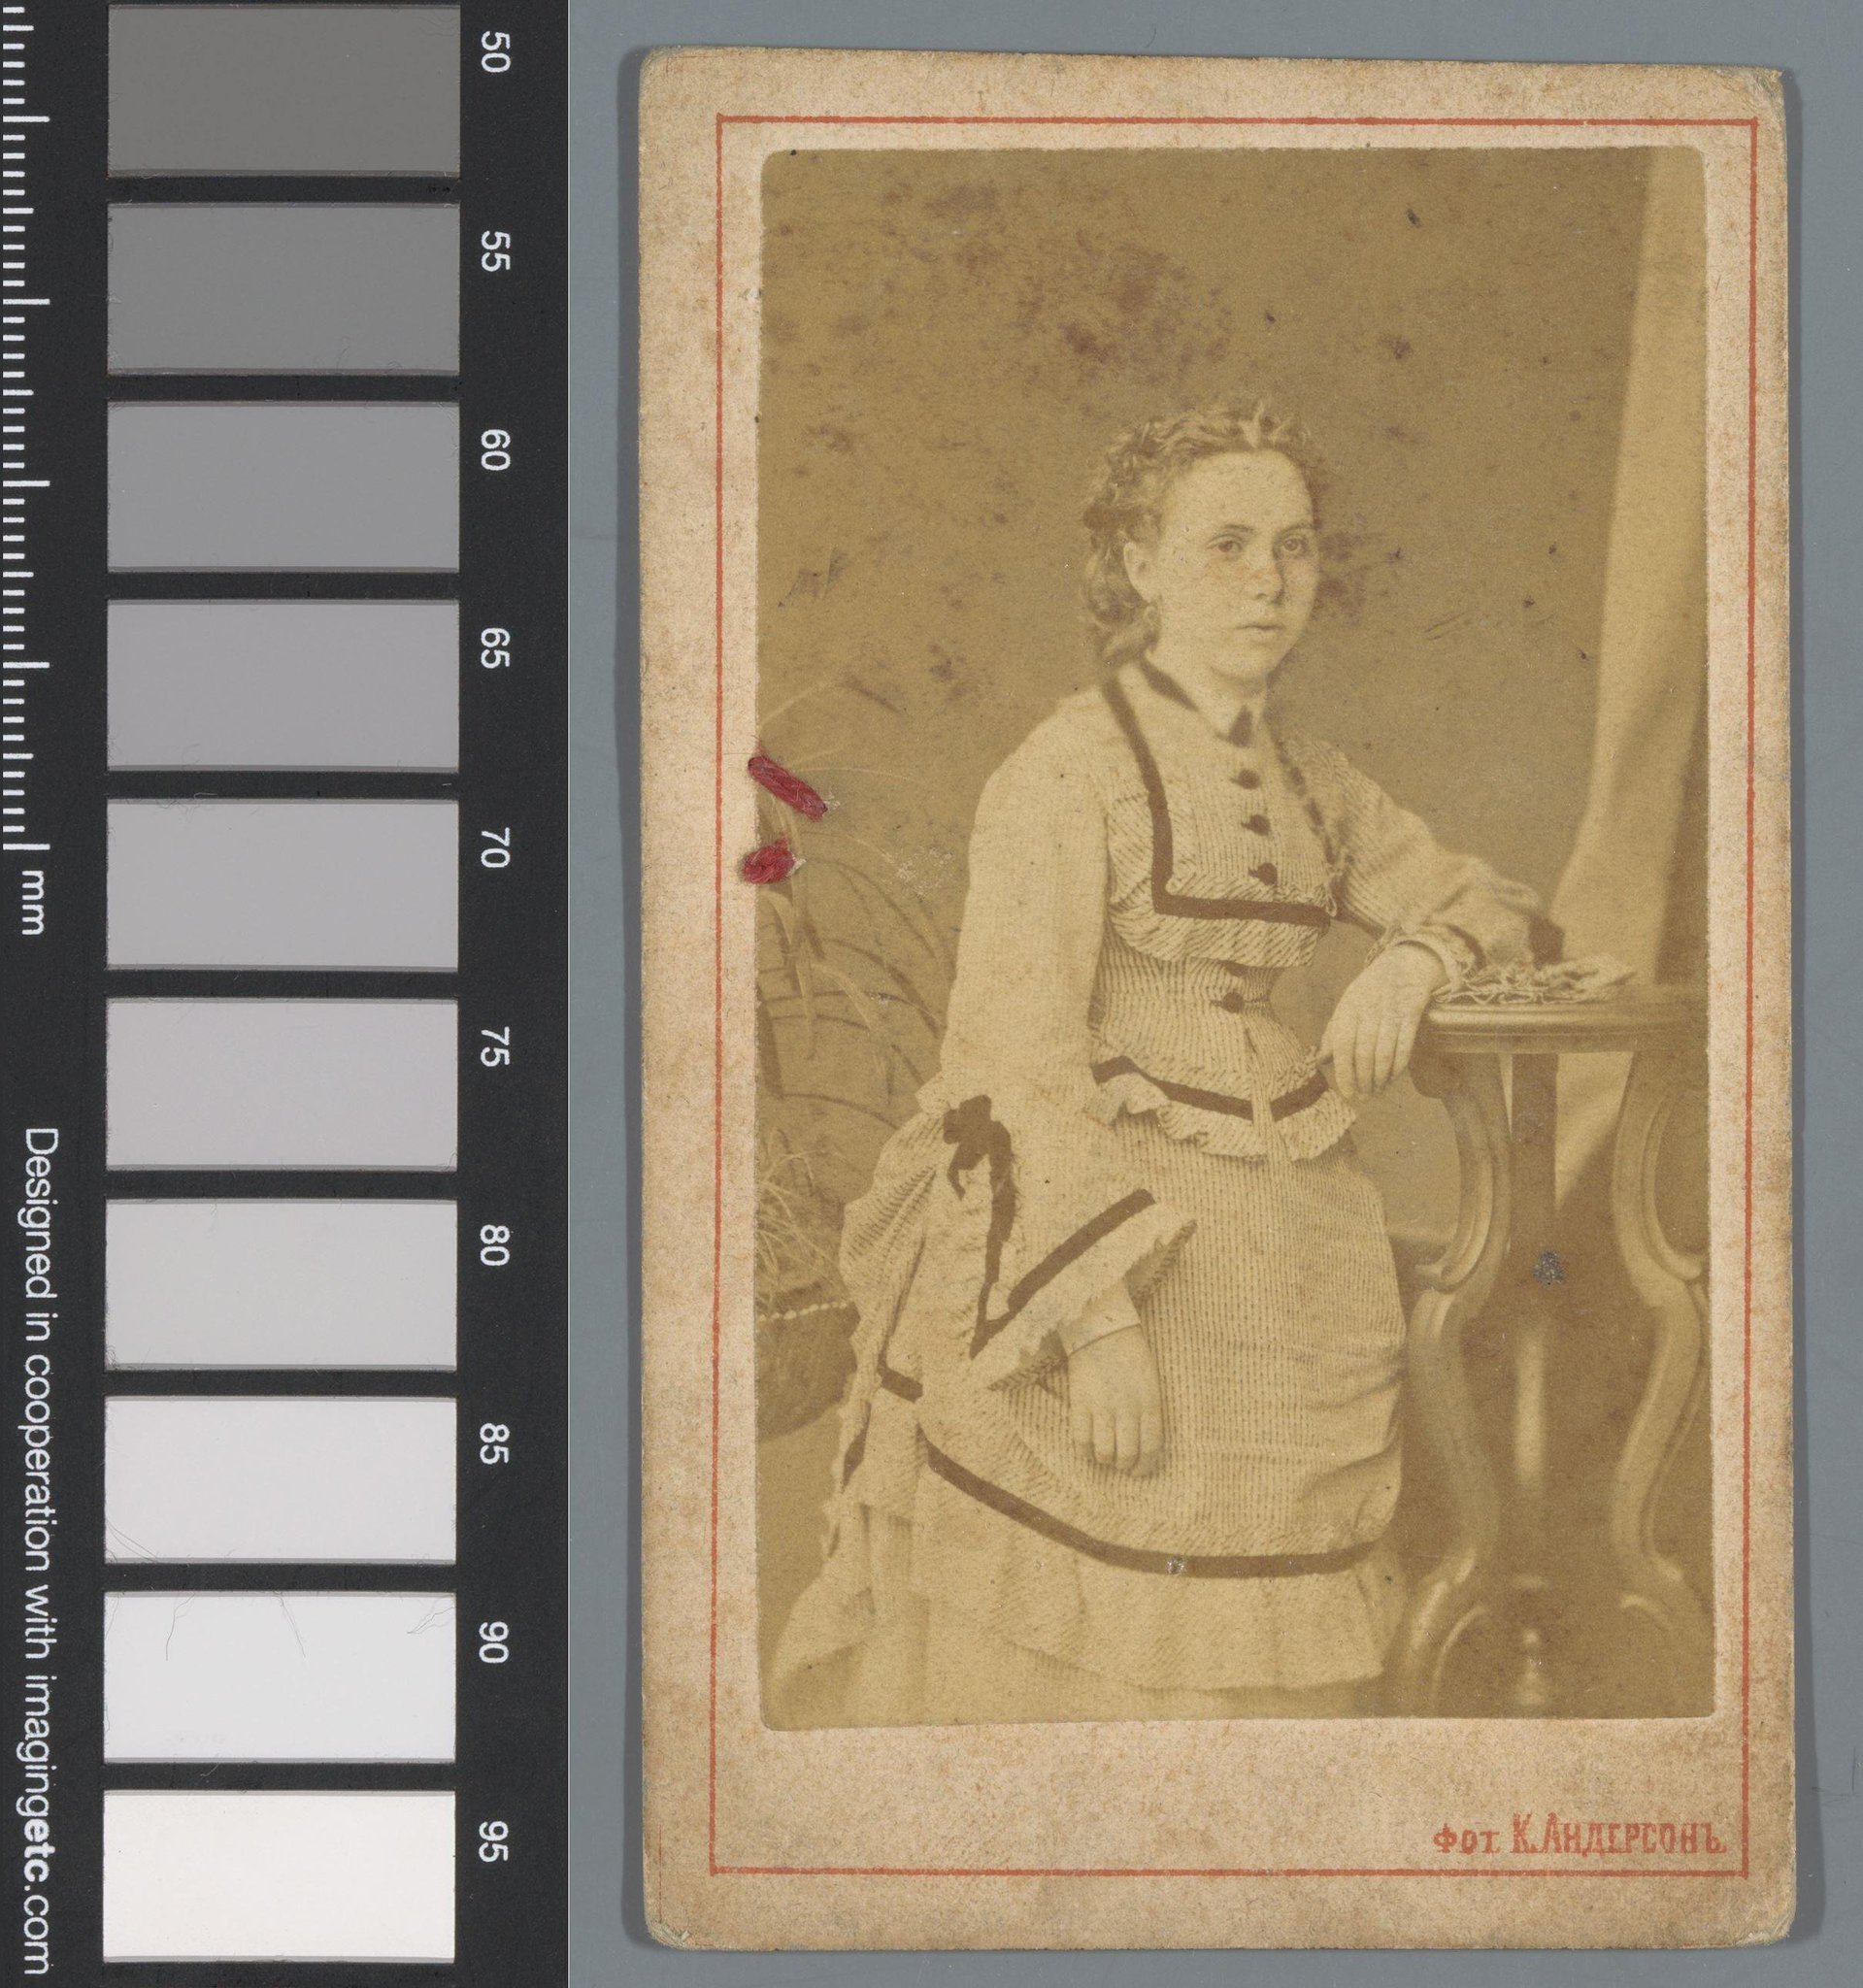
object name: carte de visite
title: Portret van een onbekende vrouw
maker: k. anderson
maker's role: fotograaf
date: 1870-1890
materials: cardboard, paper, yarns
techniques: albumen print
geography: sint-petersburg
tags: historical persons - bb - woman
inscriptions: inscription